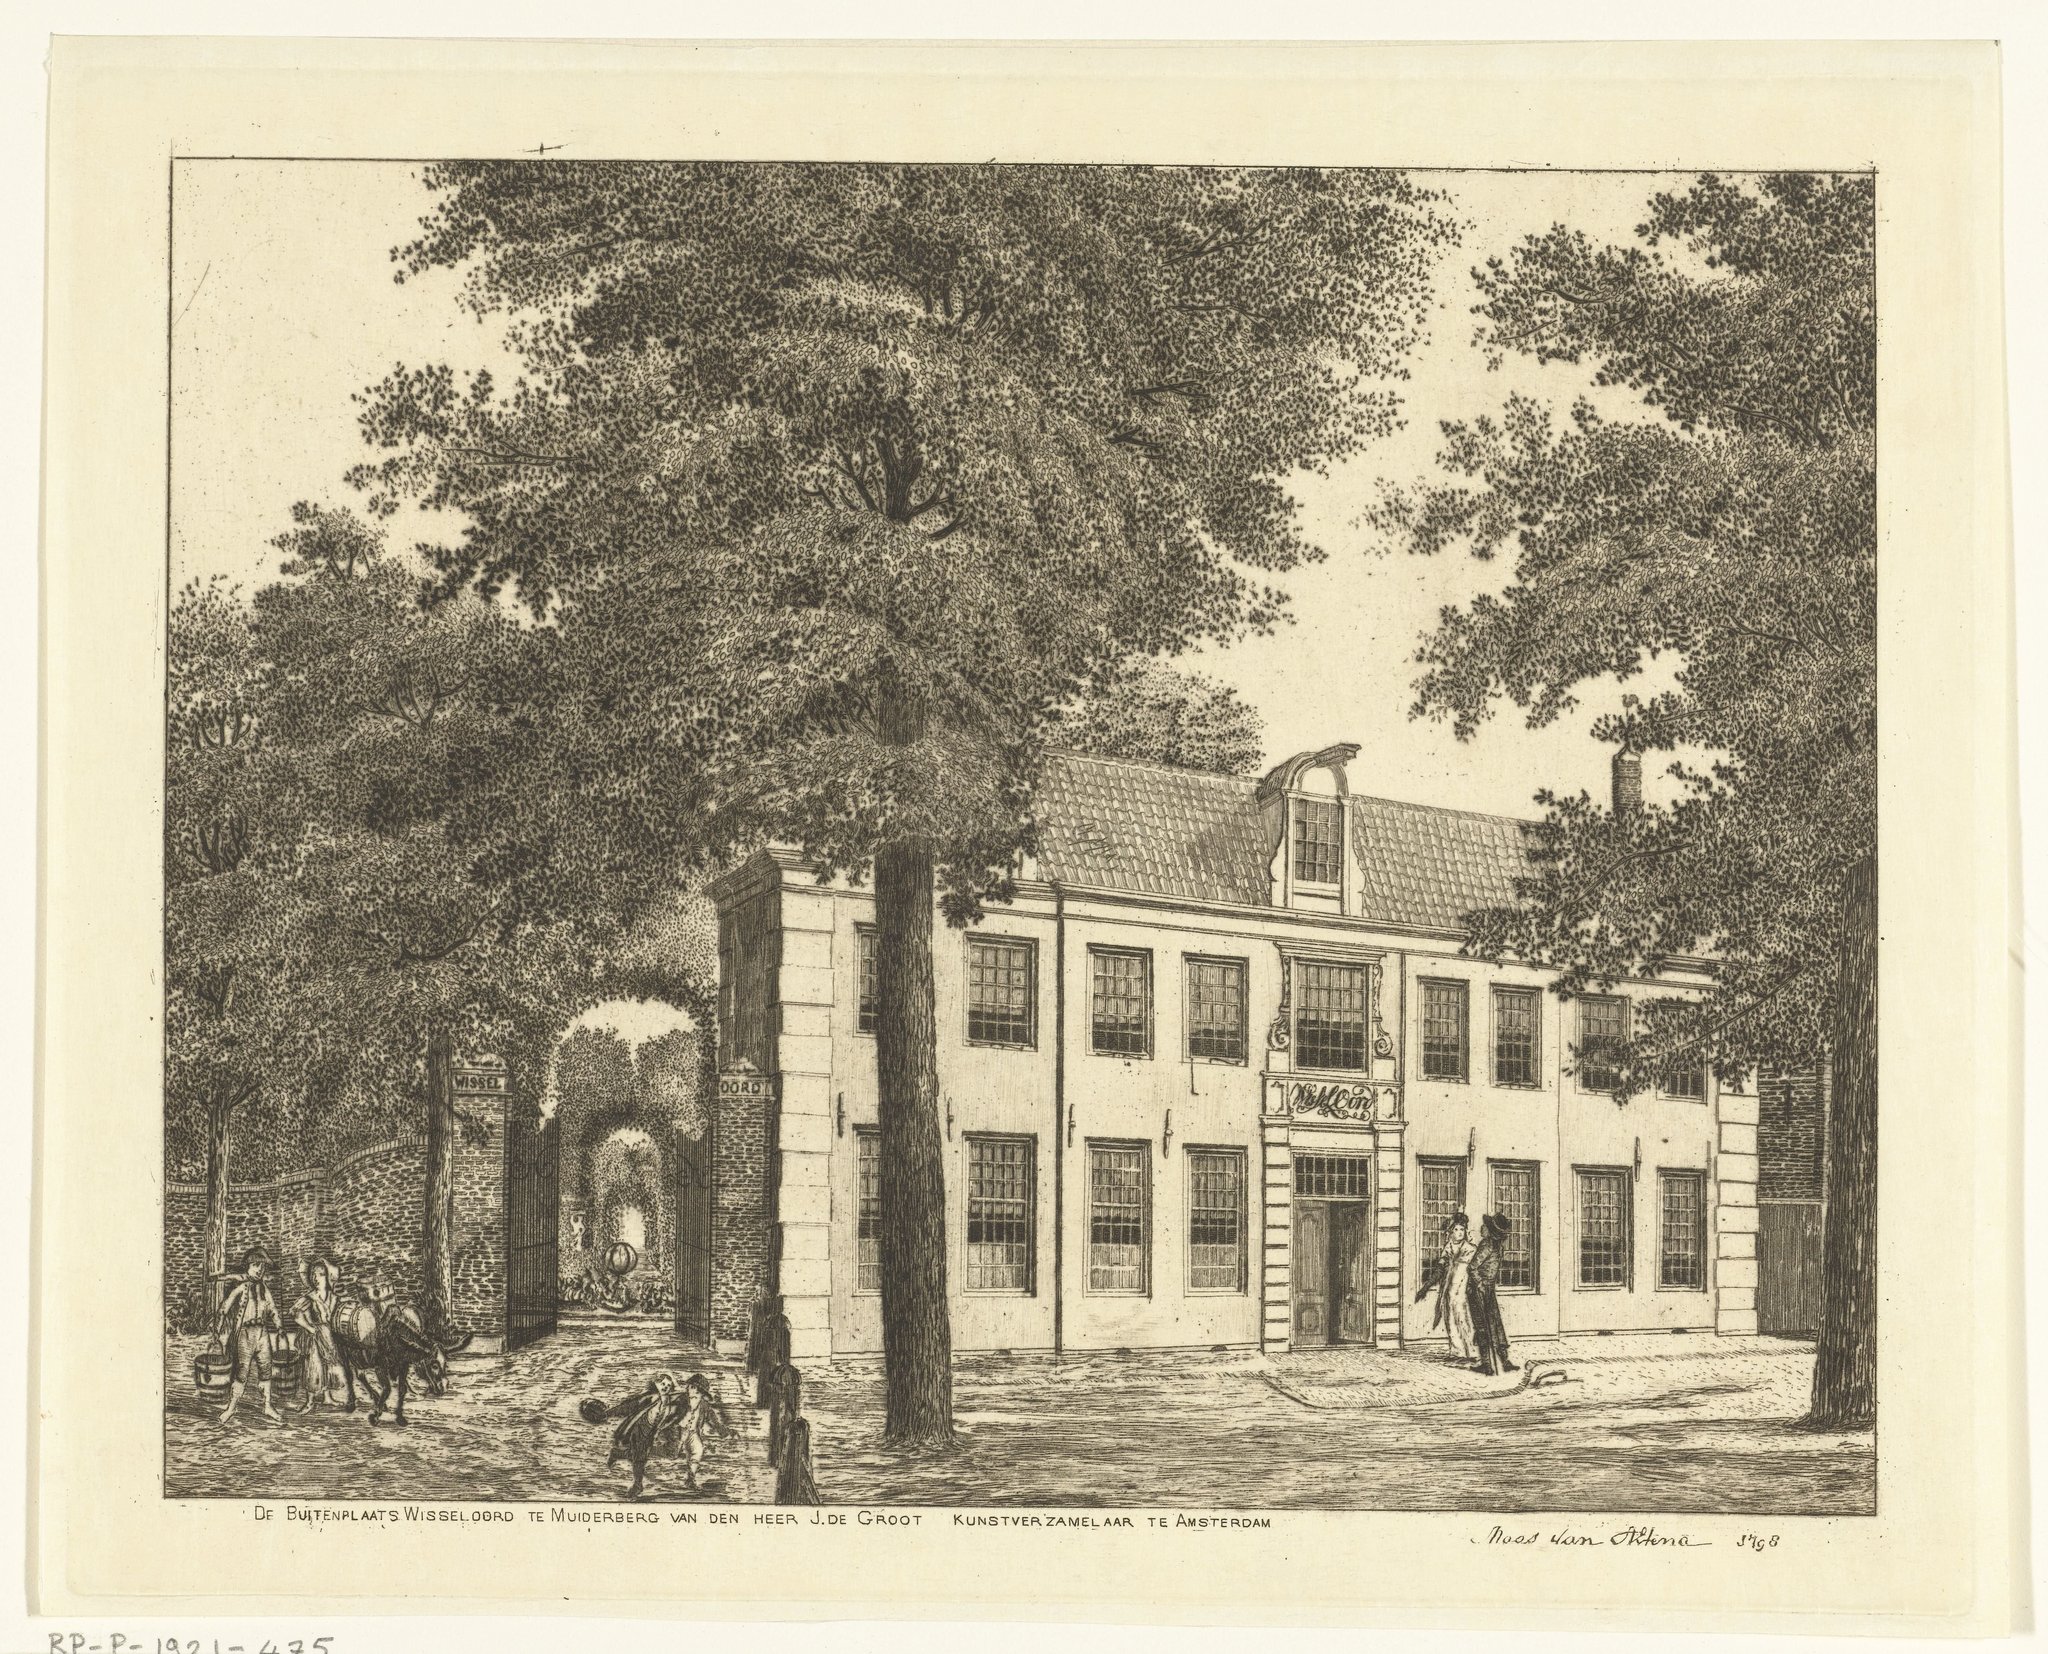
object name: print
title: Wisseloord te Muiderberg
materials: paper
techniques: etching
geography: netherlands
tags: rural housing, e.g. country-house, villa, cottage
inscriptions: collector's mark: Lugt 2228, collector's mark: Lugt 2233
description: Wisseloord te Muiderberg, buitenplaats van de kunstverzamelaar J. de Groot uit Amsterdam. Met een onderschrift van een regel in het Nederlands.